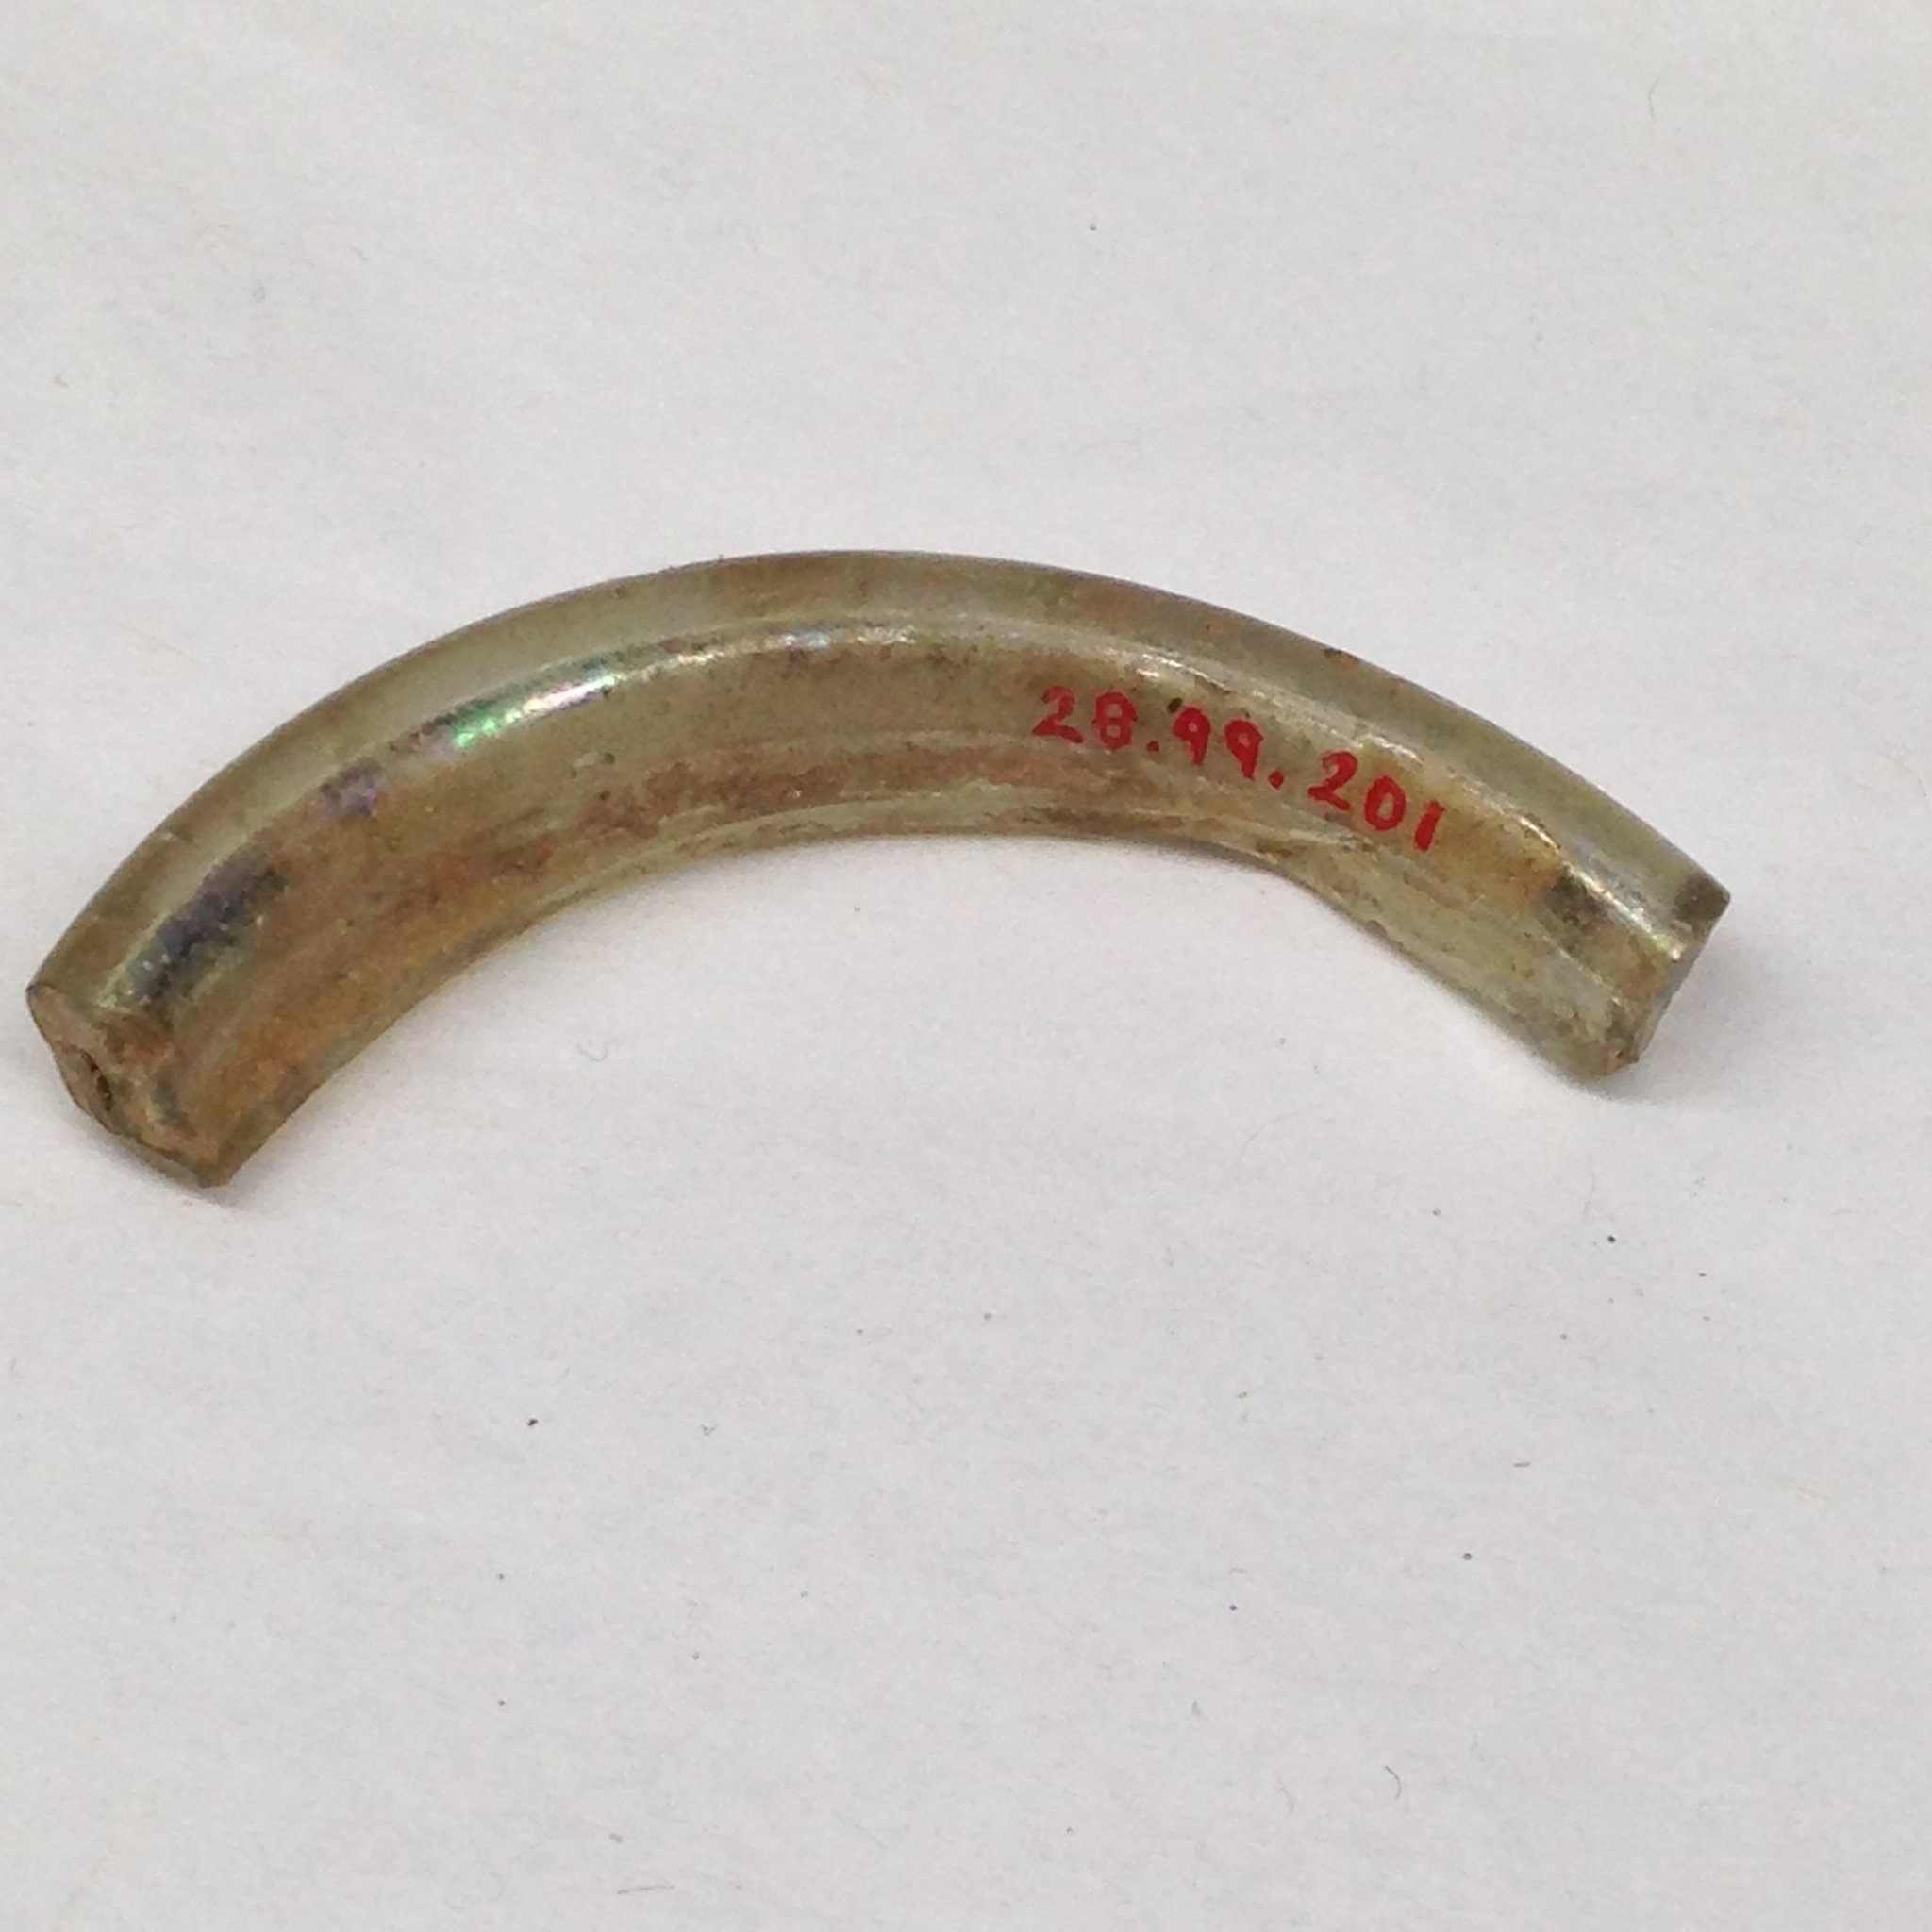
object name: fragment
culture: european or middle eastern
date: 1150-1250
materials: ceramic, glass